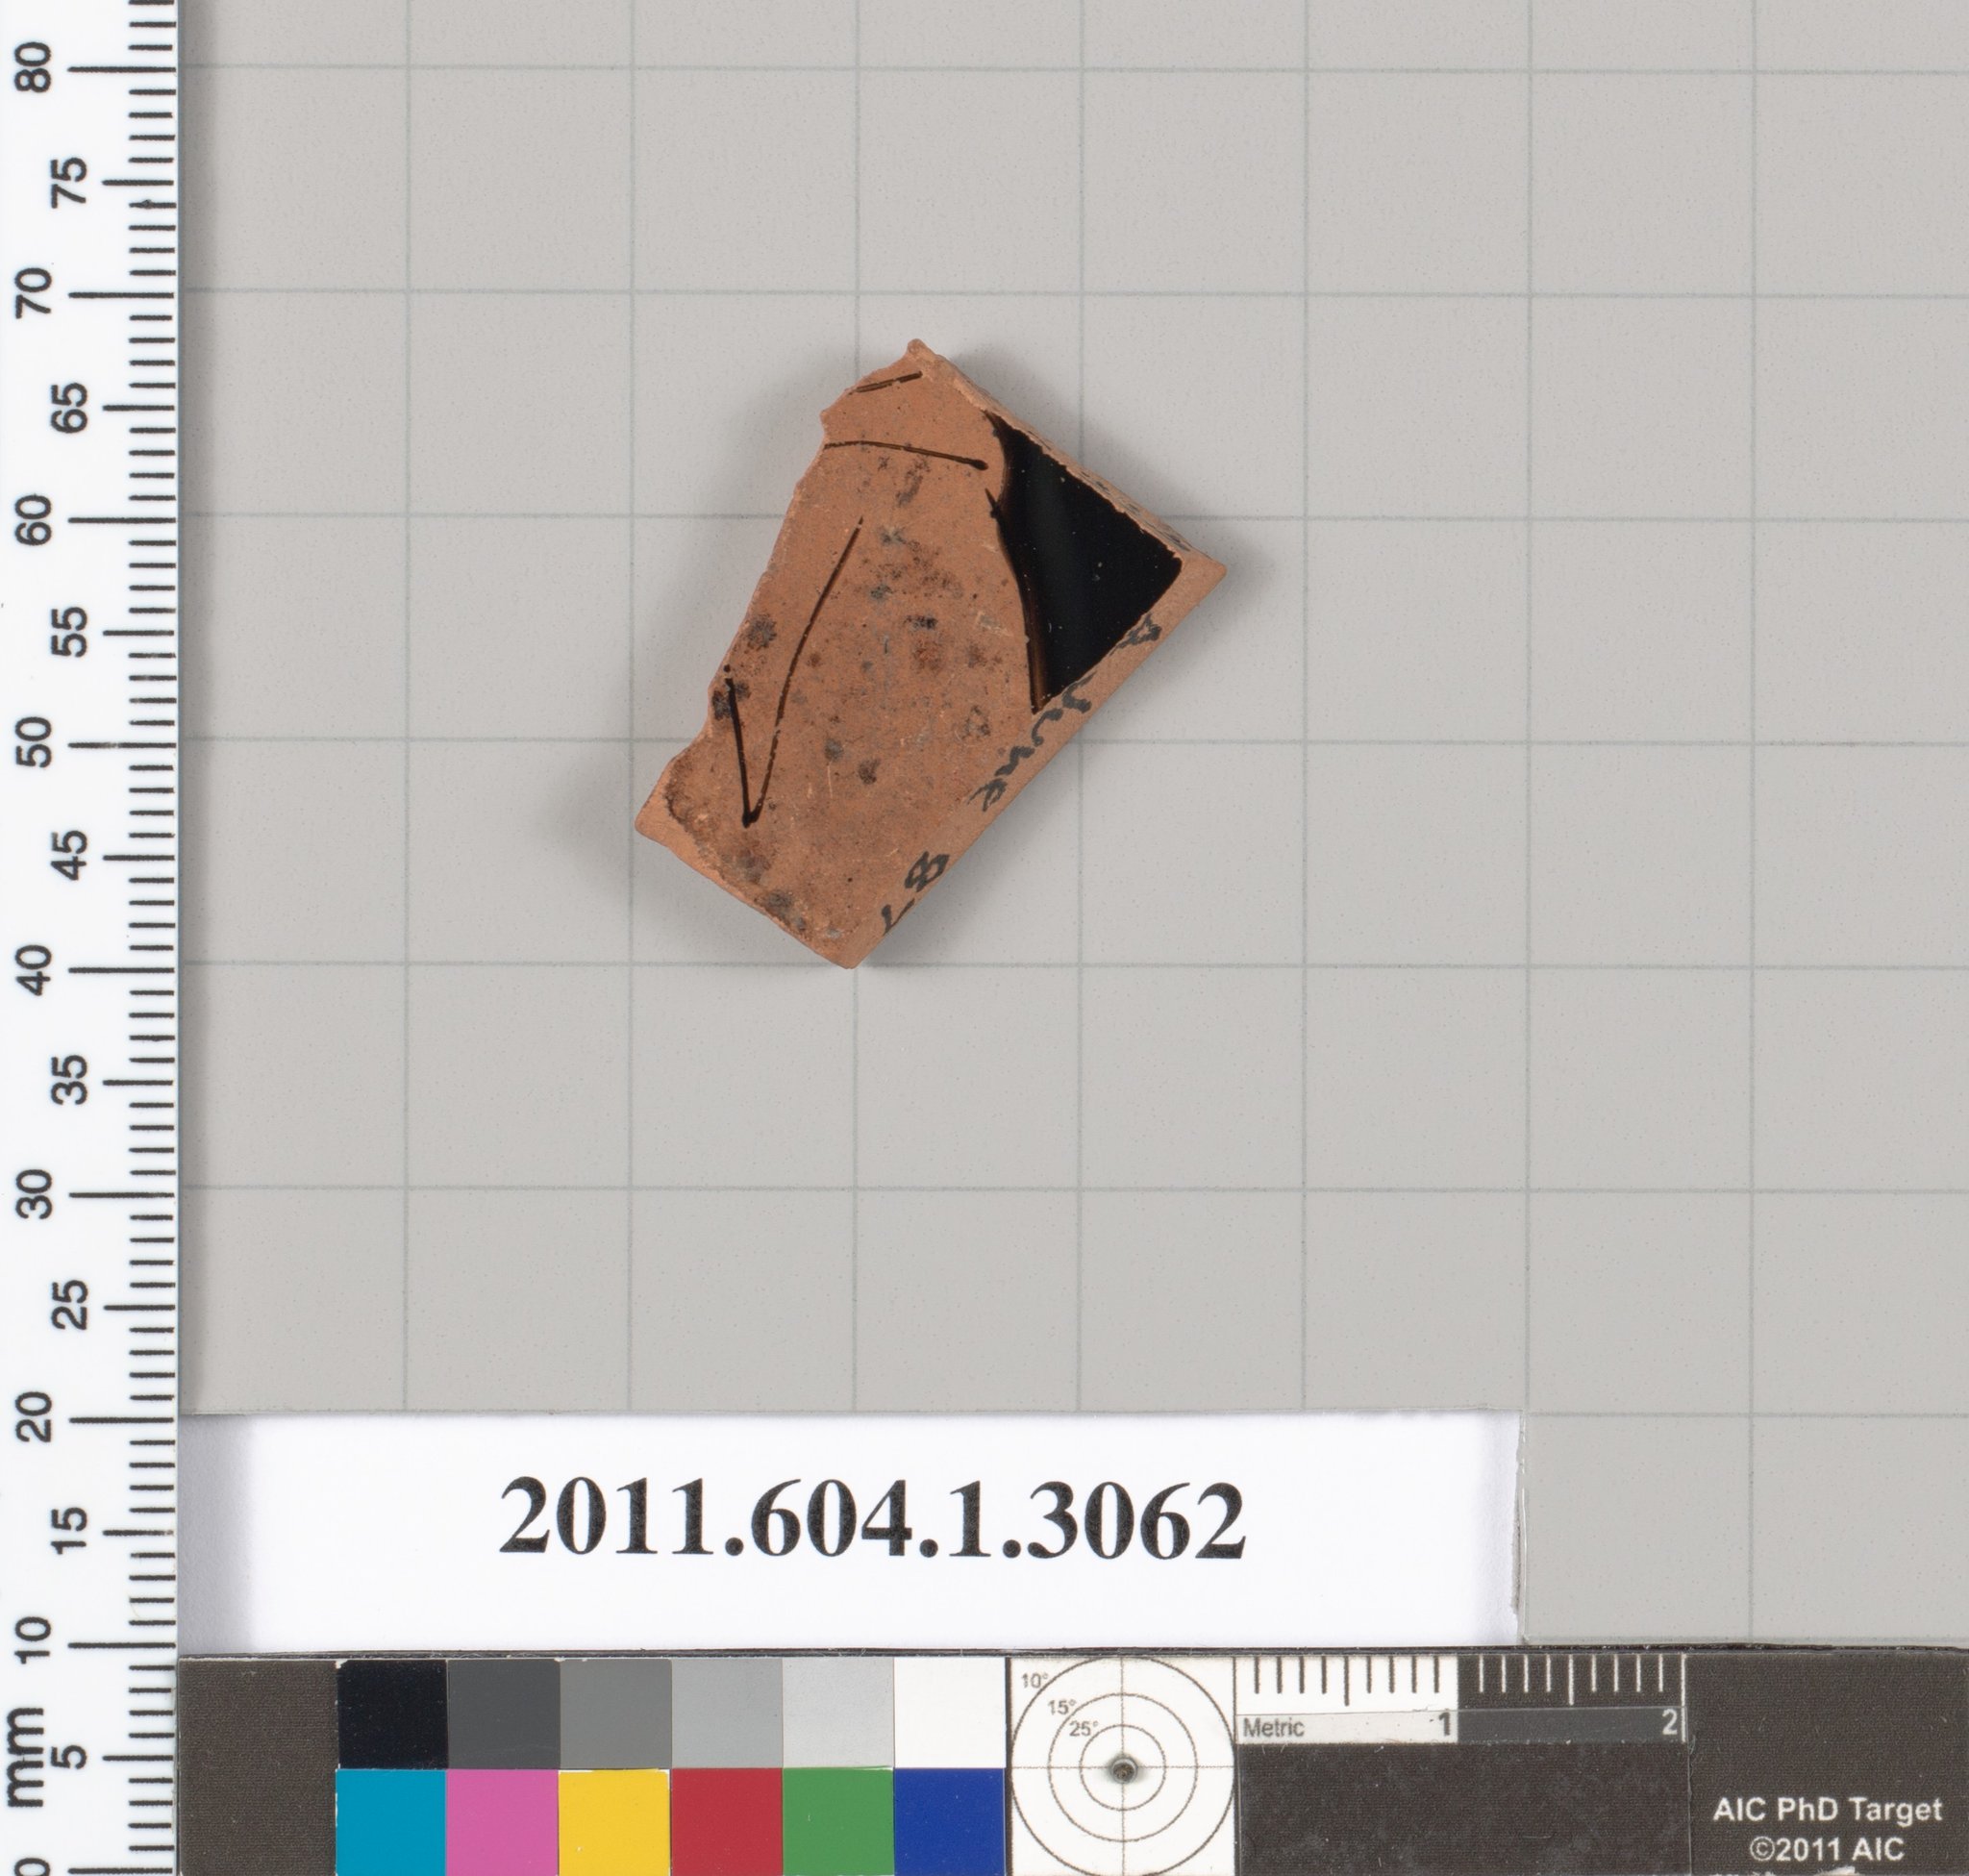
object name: kylix fragment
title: Terracotta fragment of a kylix (drinking cup)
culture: greek, attic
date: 500-480 BCE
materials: terracotta